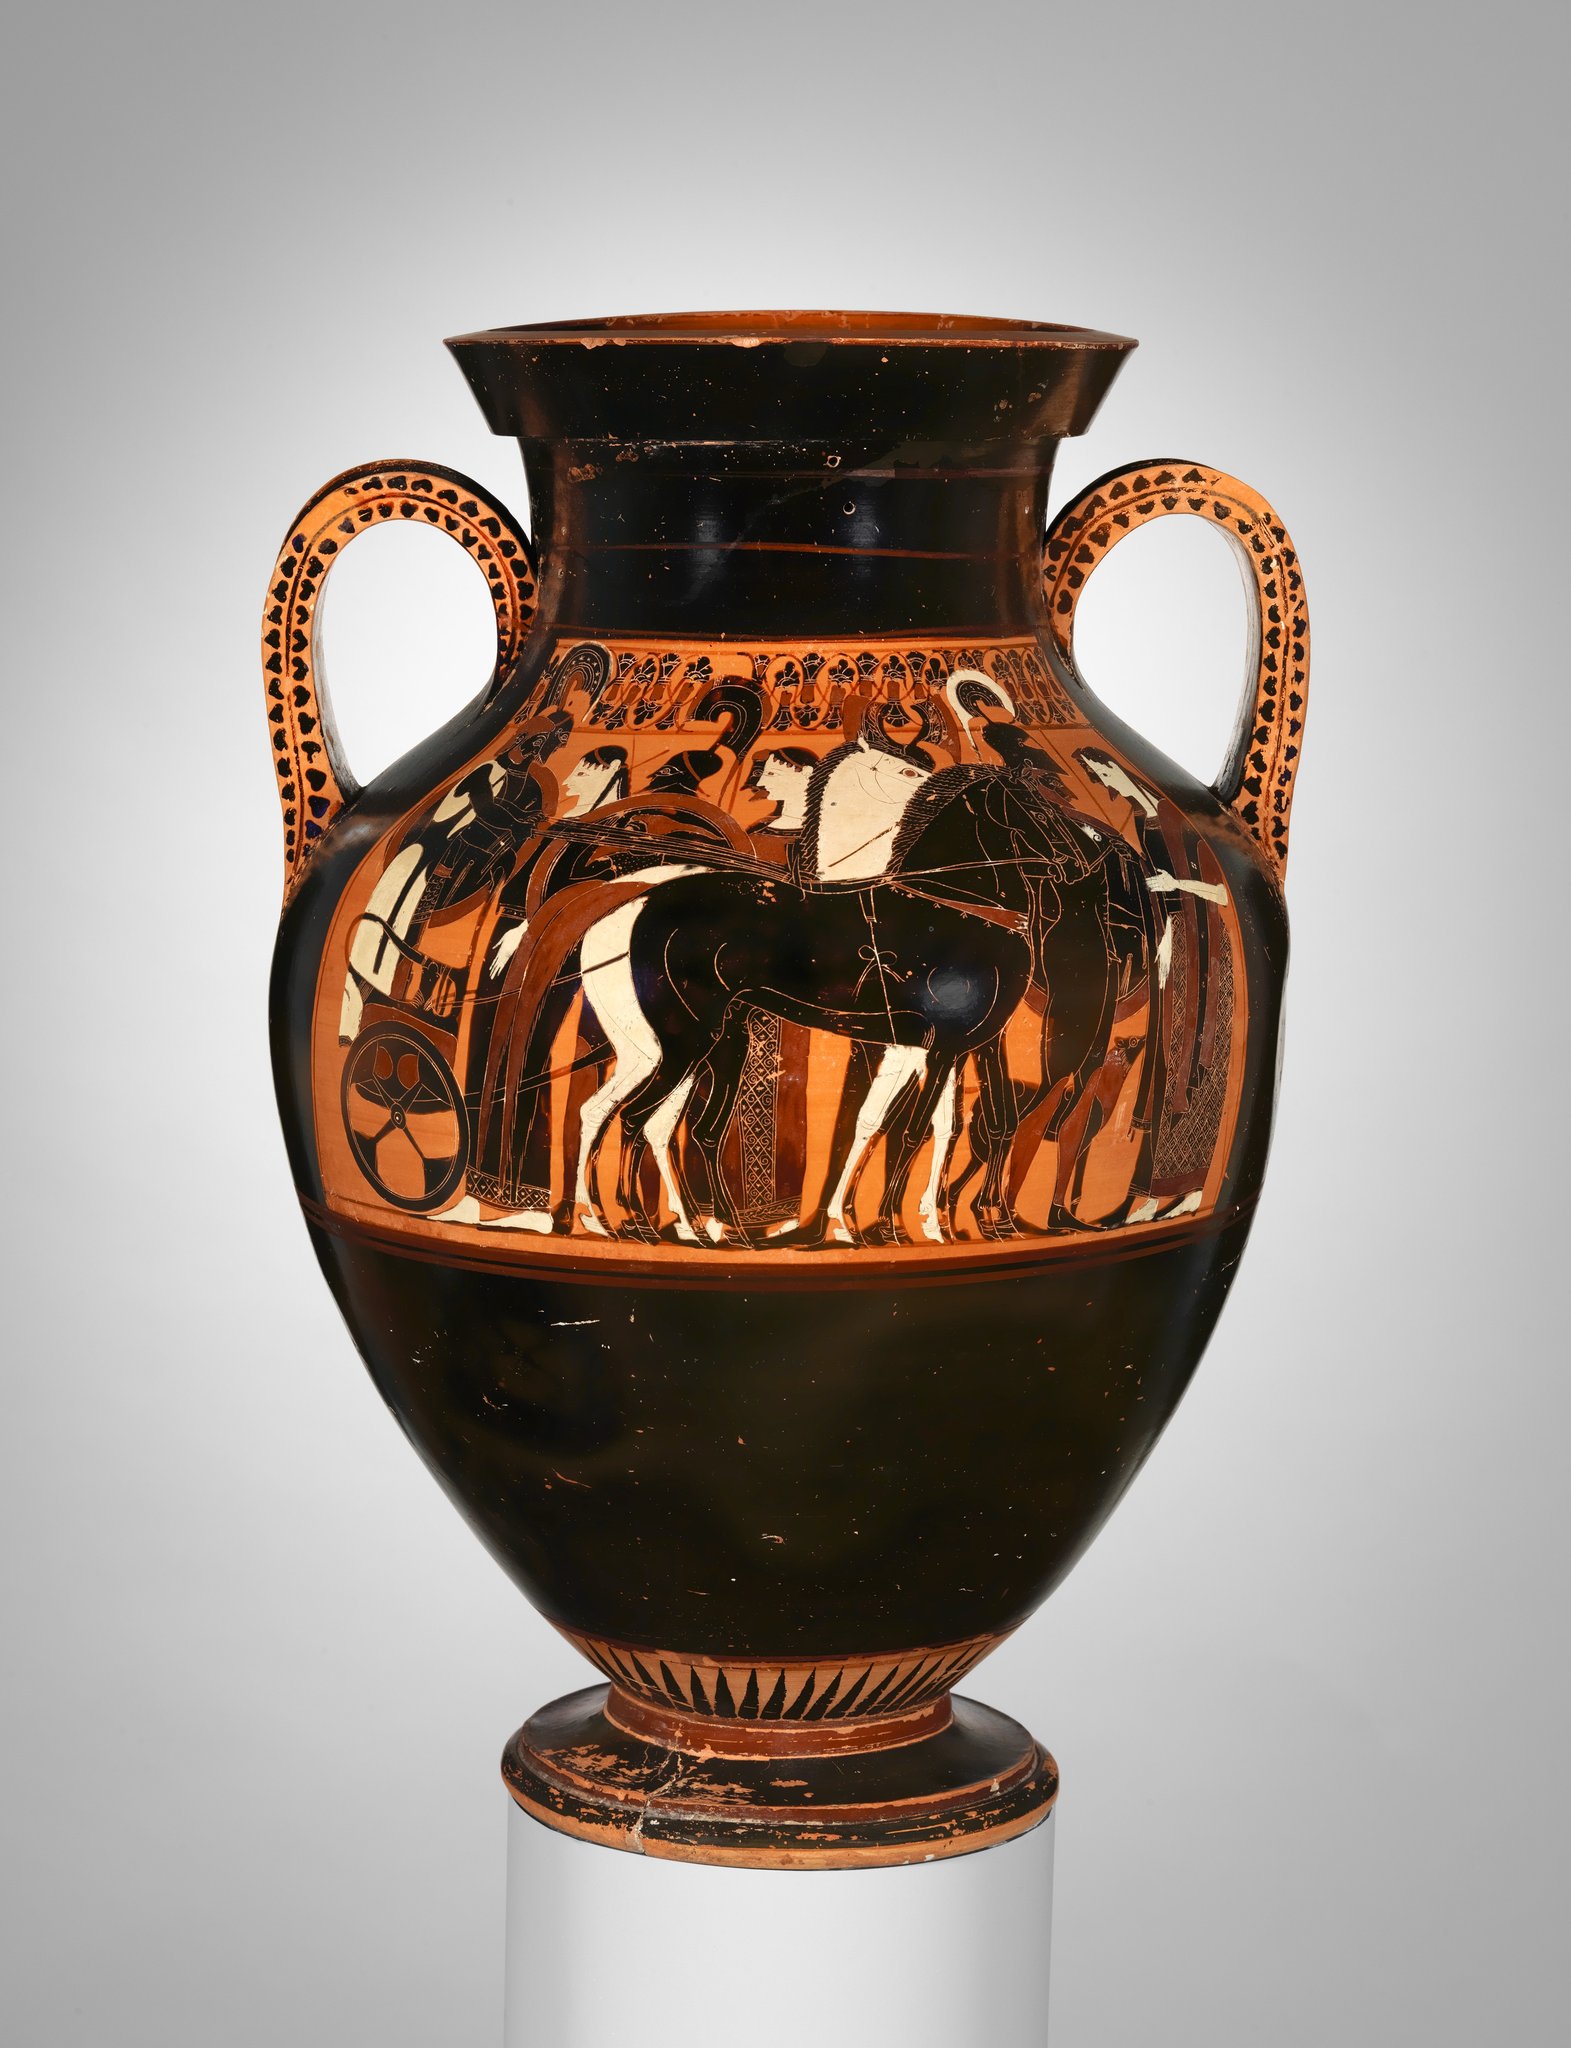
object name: amphora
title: Terracotta amphora (jar)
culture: greek, attic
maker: swing painter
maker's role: artist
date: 540-530 BCE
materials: terracotta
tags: soldiers,men,women,horses,chariots